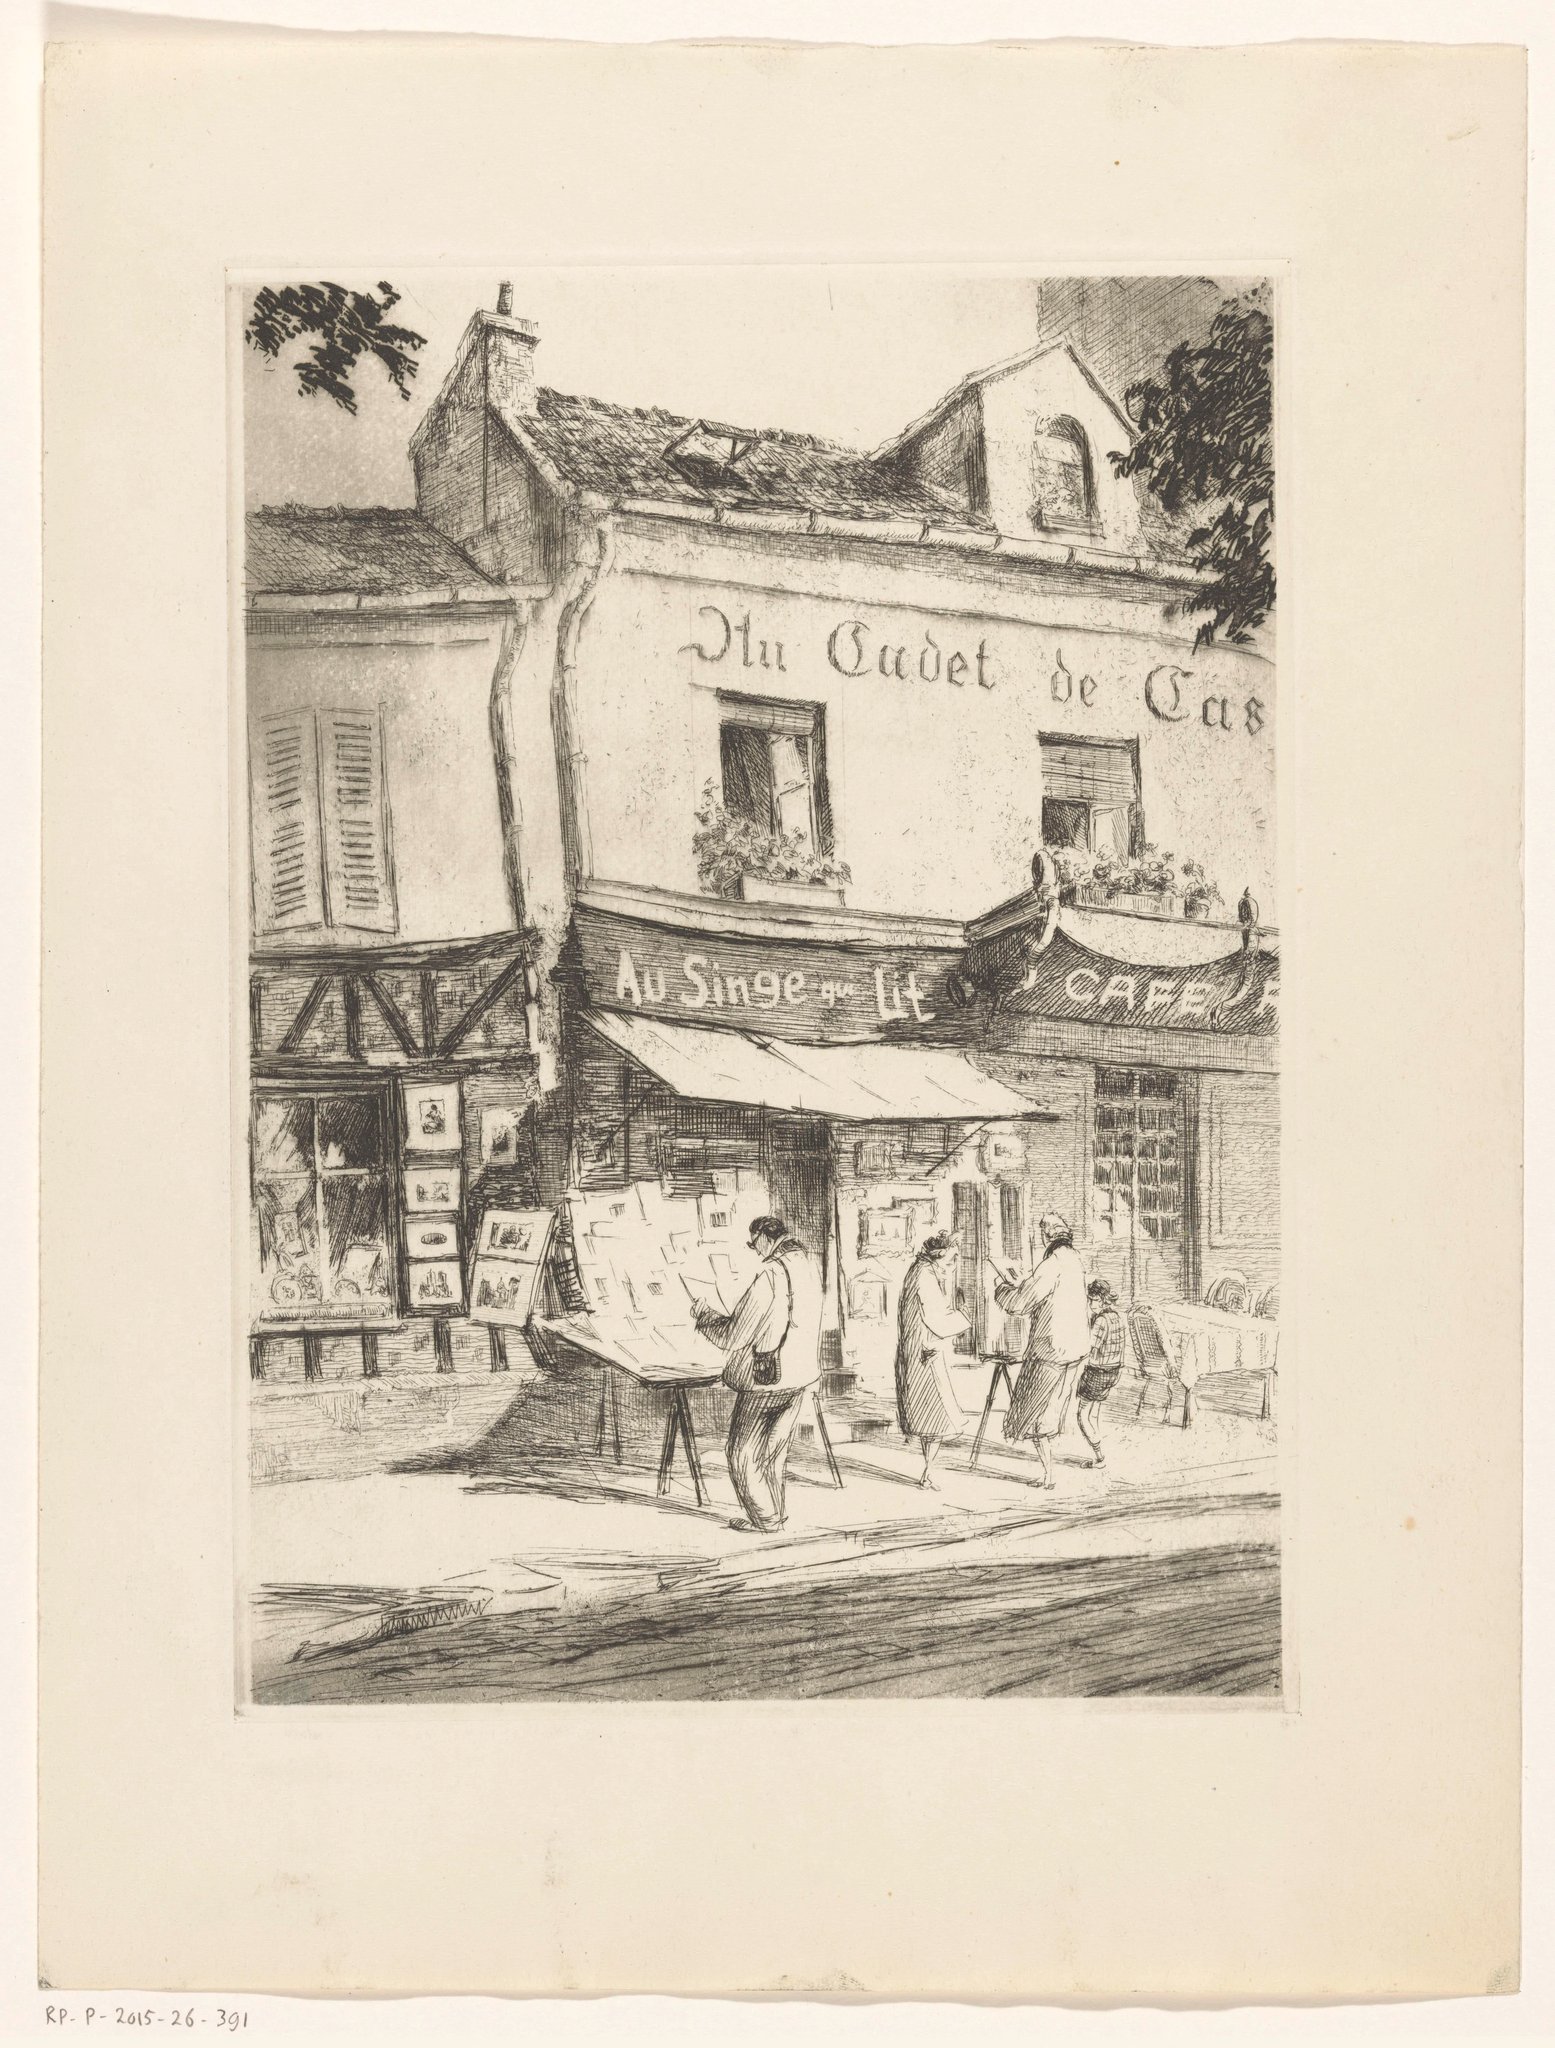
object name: print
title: Boekhandel Au Singe qui lit te Parijs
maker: Anonymous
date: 1908-1935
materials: paper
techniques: drypoint, etching, intaglio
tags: pavement, terrace in front of inn or restaurant, shop-window, show-window, book-shop, bookseller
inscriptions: collector's mark: Lugt 2228, collector's mark: Lugt 4780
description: Gezicht op het exterieur van de boekhandel, gevestigd in hotel Au Cadet de Cascogne aan het Place du Tertre. Een man, twee vrouwen en een kind bekijken prenten die buiten onder een overkapping zijn uitgestald.